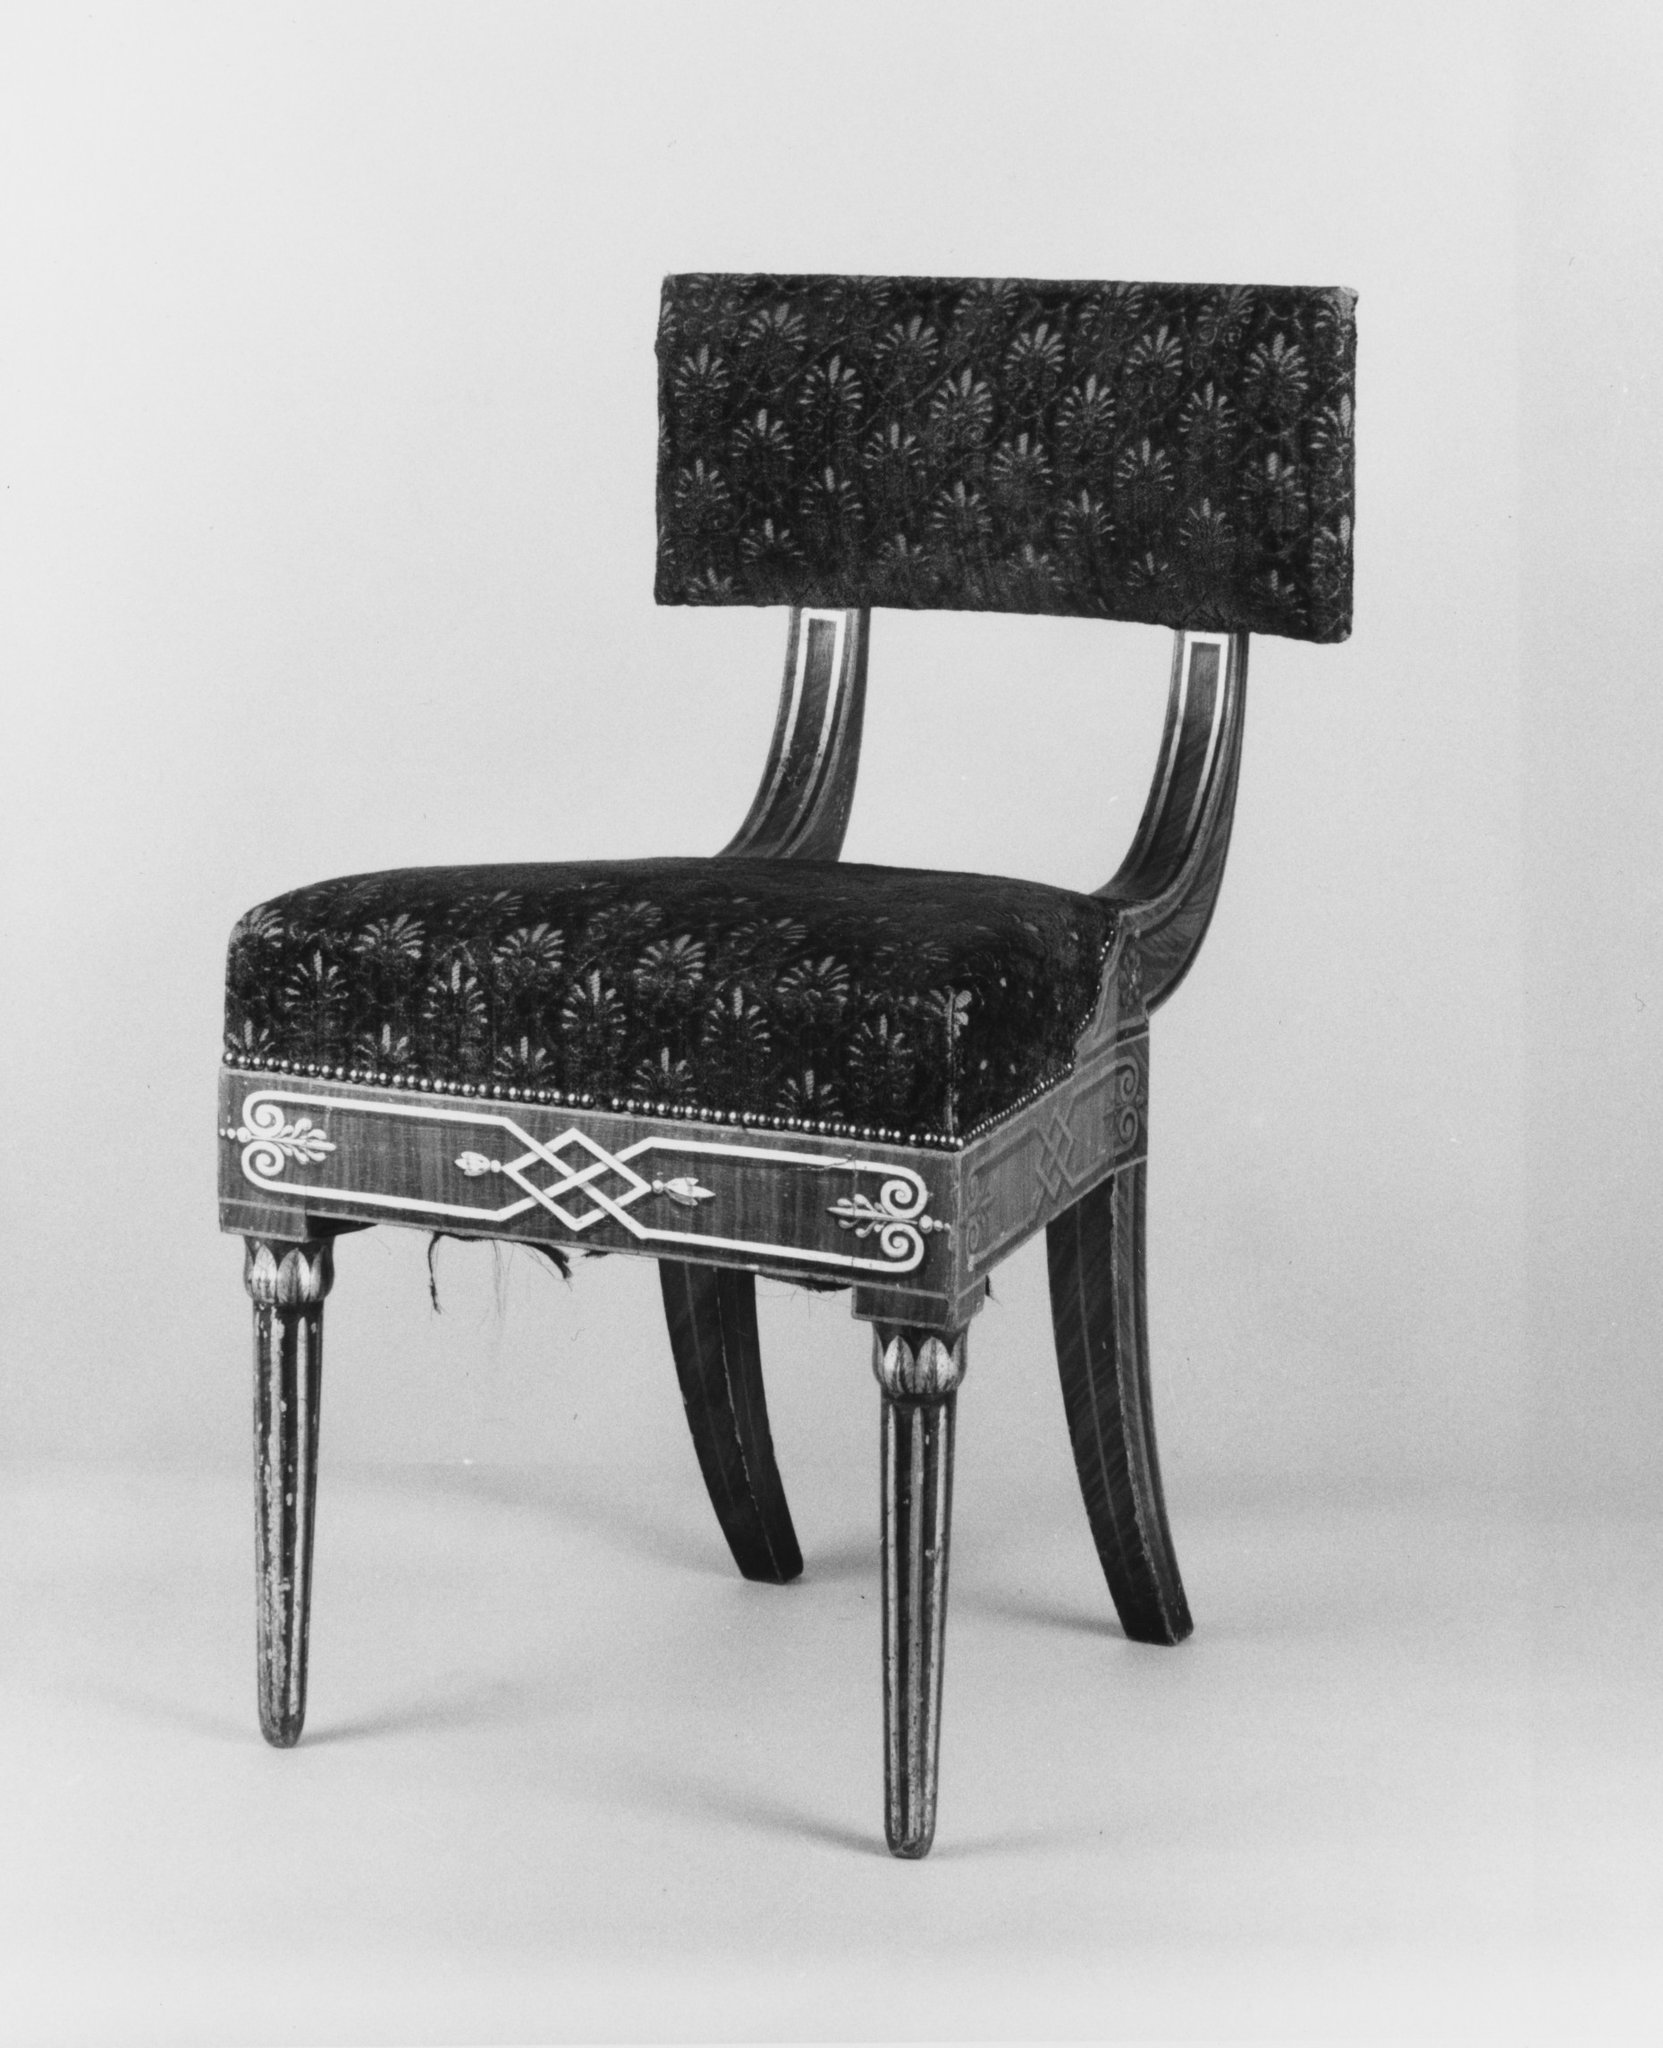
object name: side chair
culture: american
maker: john philip fondé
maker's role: maker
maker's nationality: american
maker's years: 1794-1831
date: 1816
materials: wood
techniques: gilding, painting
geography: united states